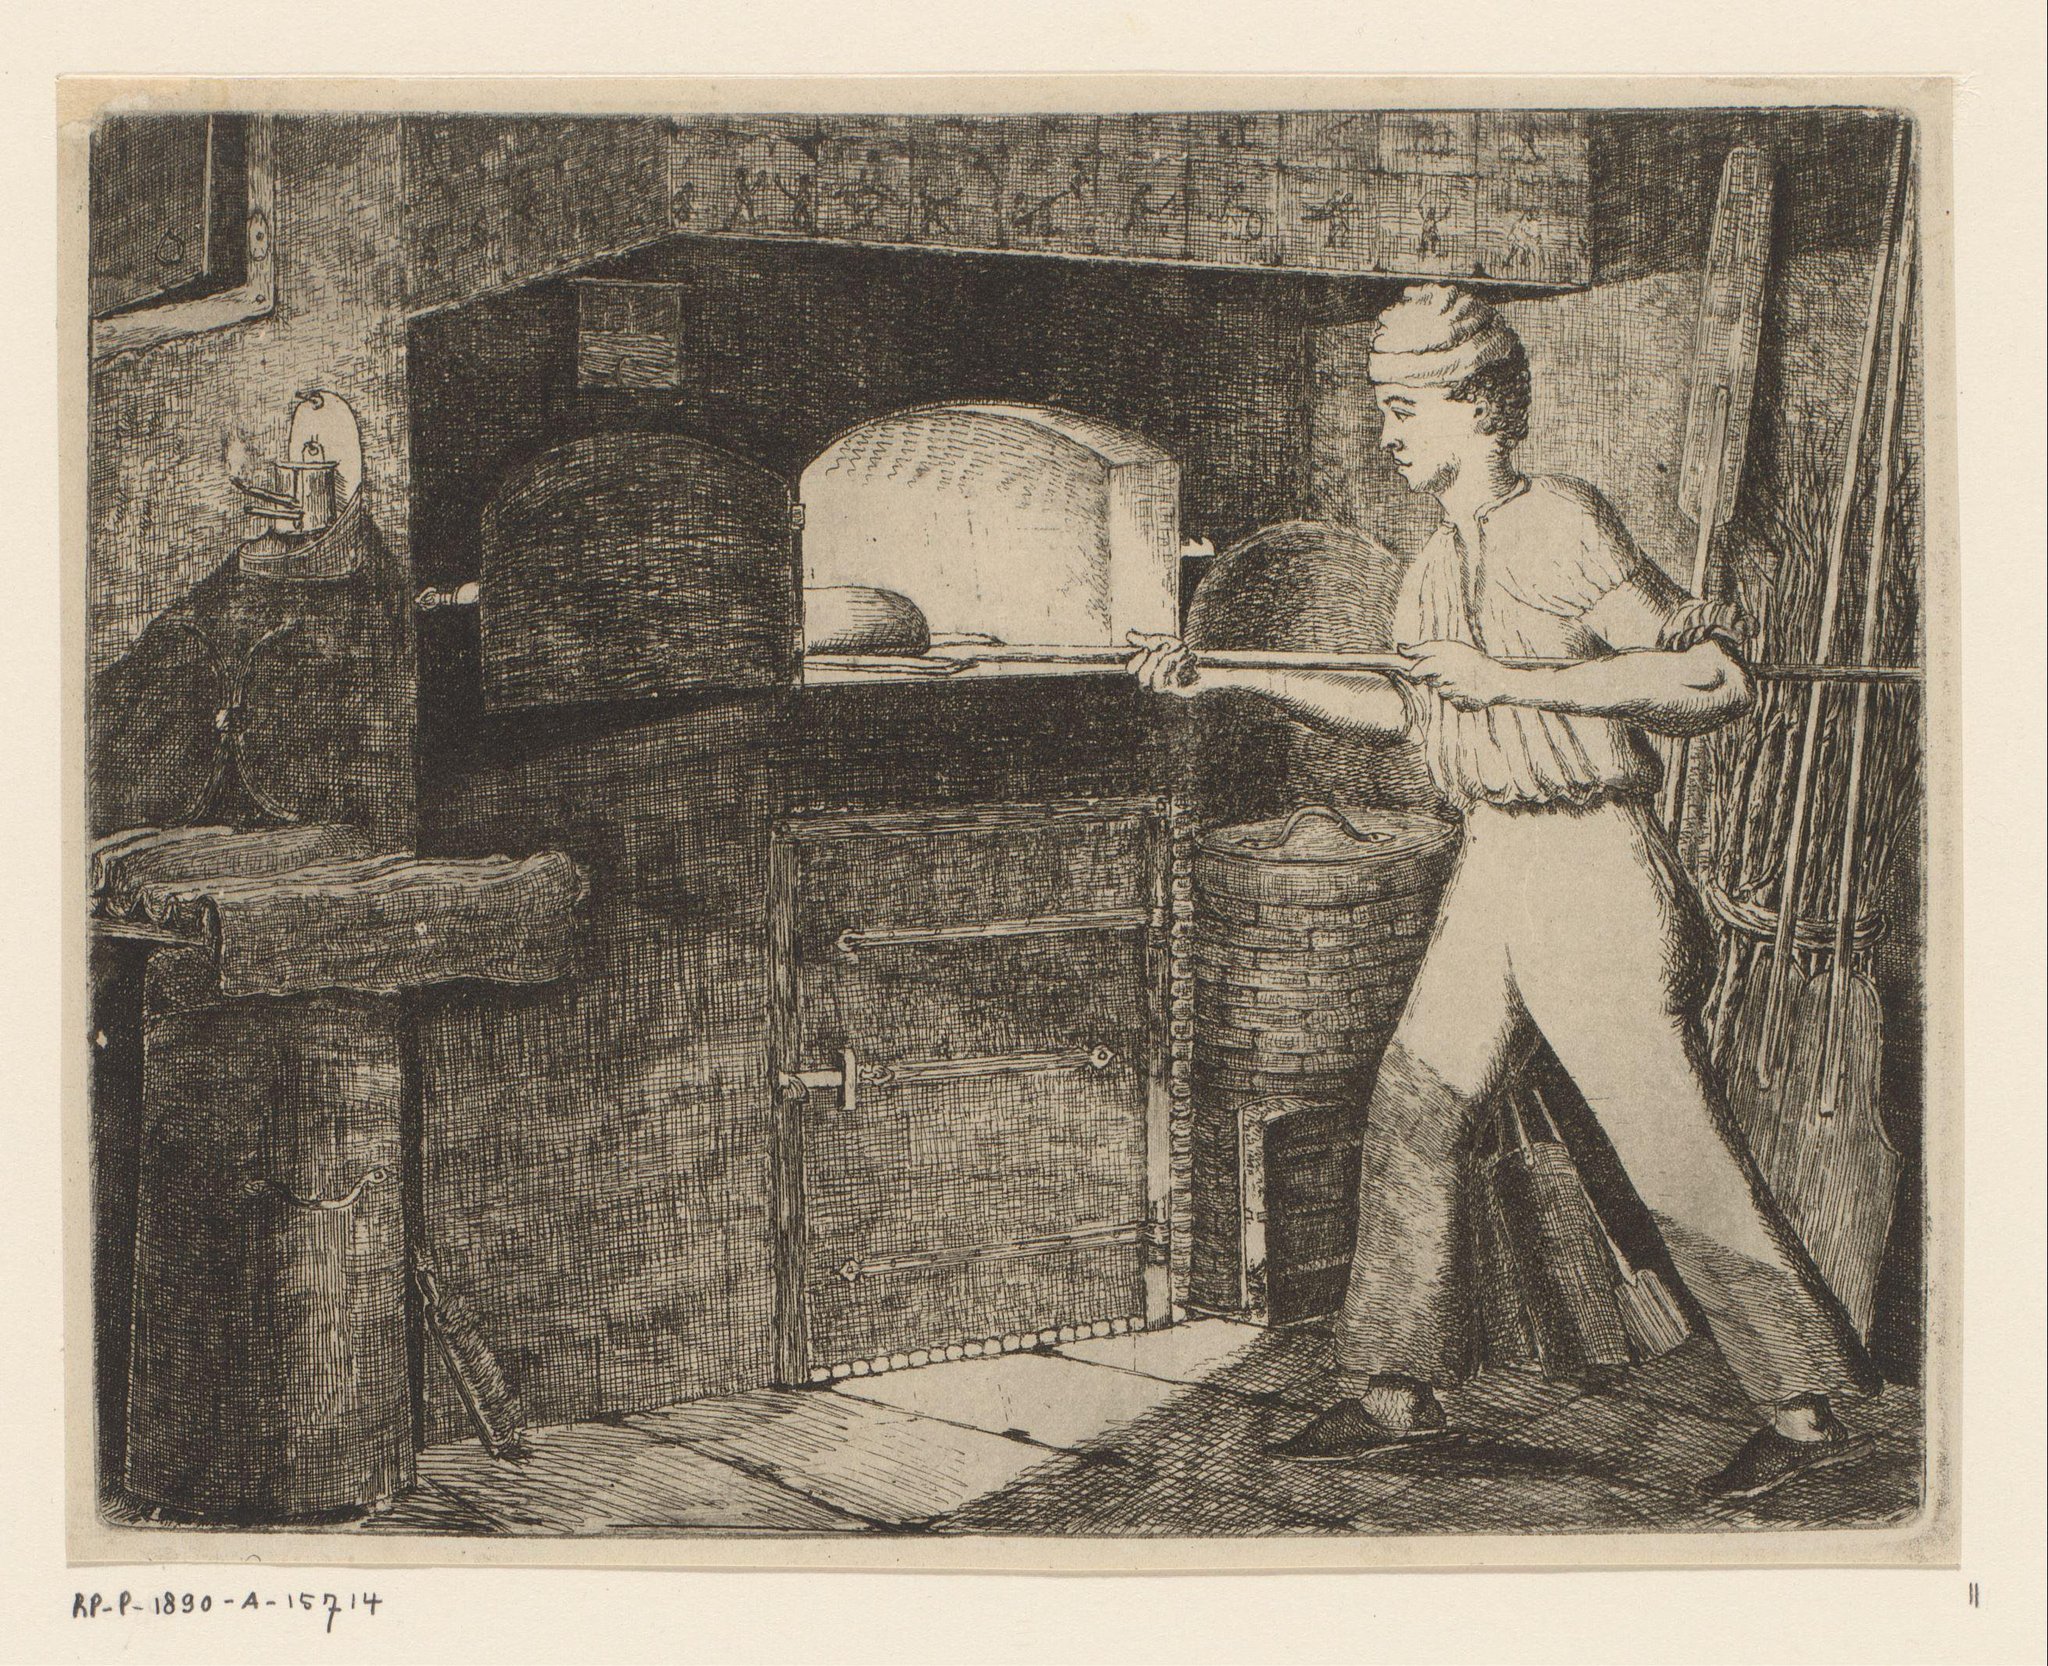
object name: print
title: Bakkerij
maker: eberhard cornelis rahms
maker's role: print maker, publisher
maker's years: 1823-1907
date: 1809-1860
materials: paper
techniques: etching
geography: oudewater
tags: baker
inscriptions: collector's mark: Lugt 2228, inscription: ‘Koper / nr 13 / Bakkerij / ECR / 3de staat September 1860’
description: In een bakkerij schuift een bakker een brood in een geopende oven. Boven de oven tegels met figuren die onder andere springtouwen, wipwappen, haasje over springen, vliegeren en hoepelen.